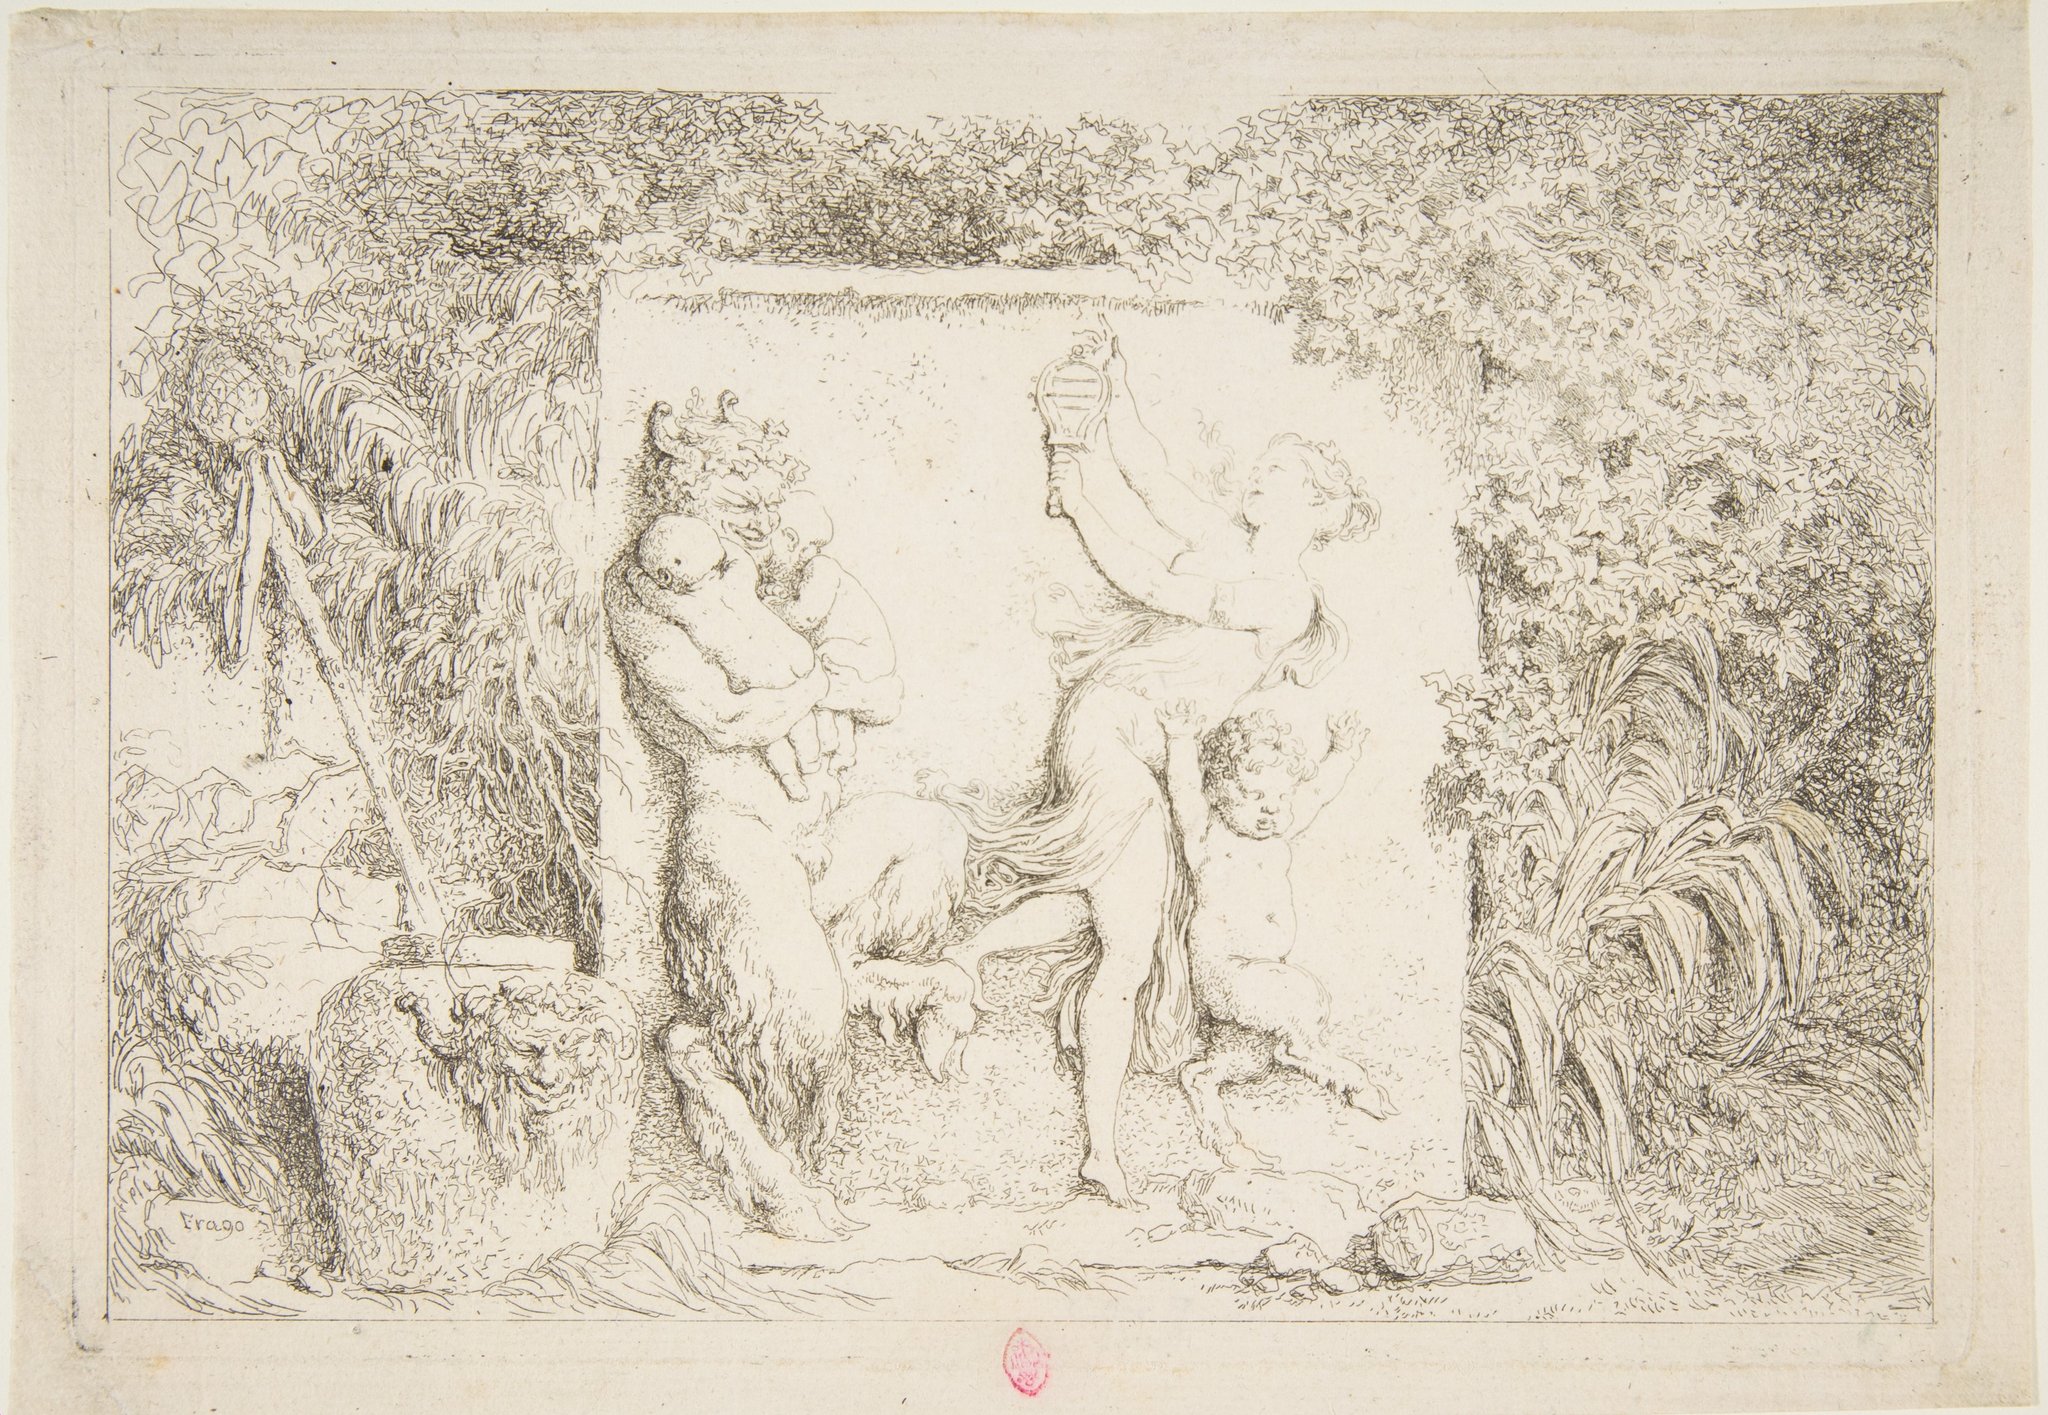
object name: print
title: Danse de satyres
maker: jean honoré fragonard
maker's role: artist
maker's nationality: french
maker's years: 1732-1806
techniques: etching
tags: dancing,satyrs